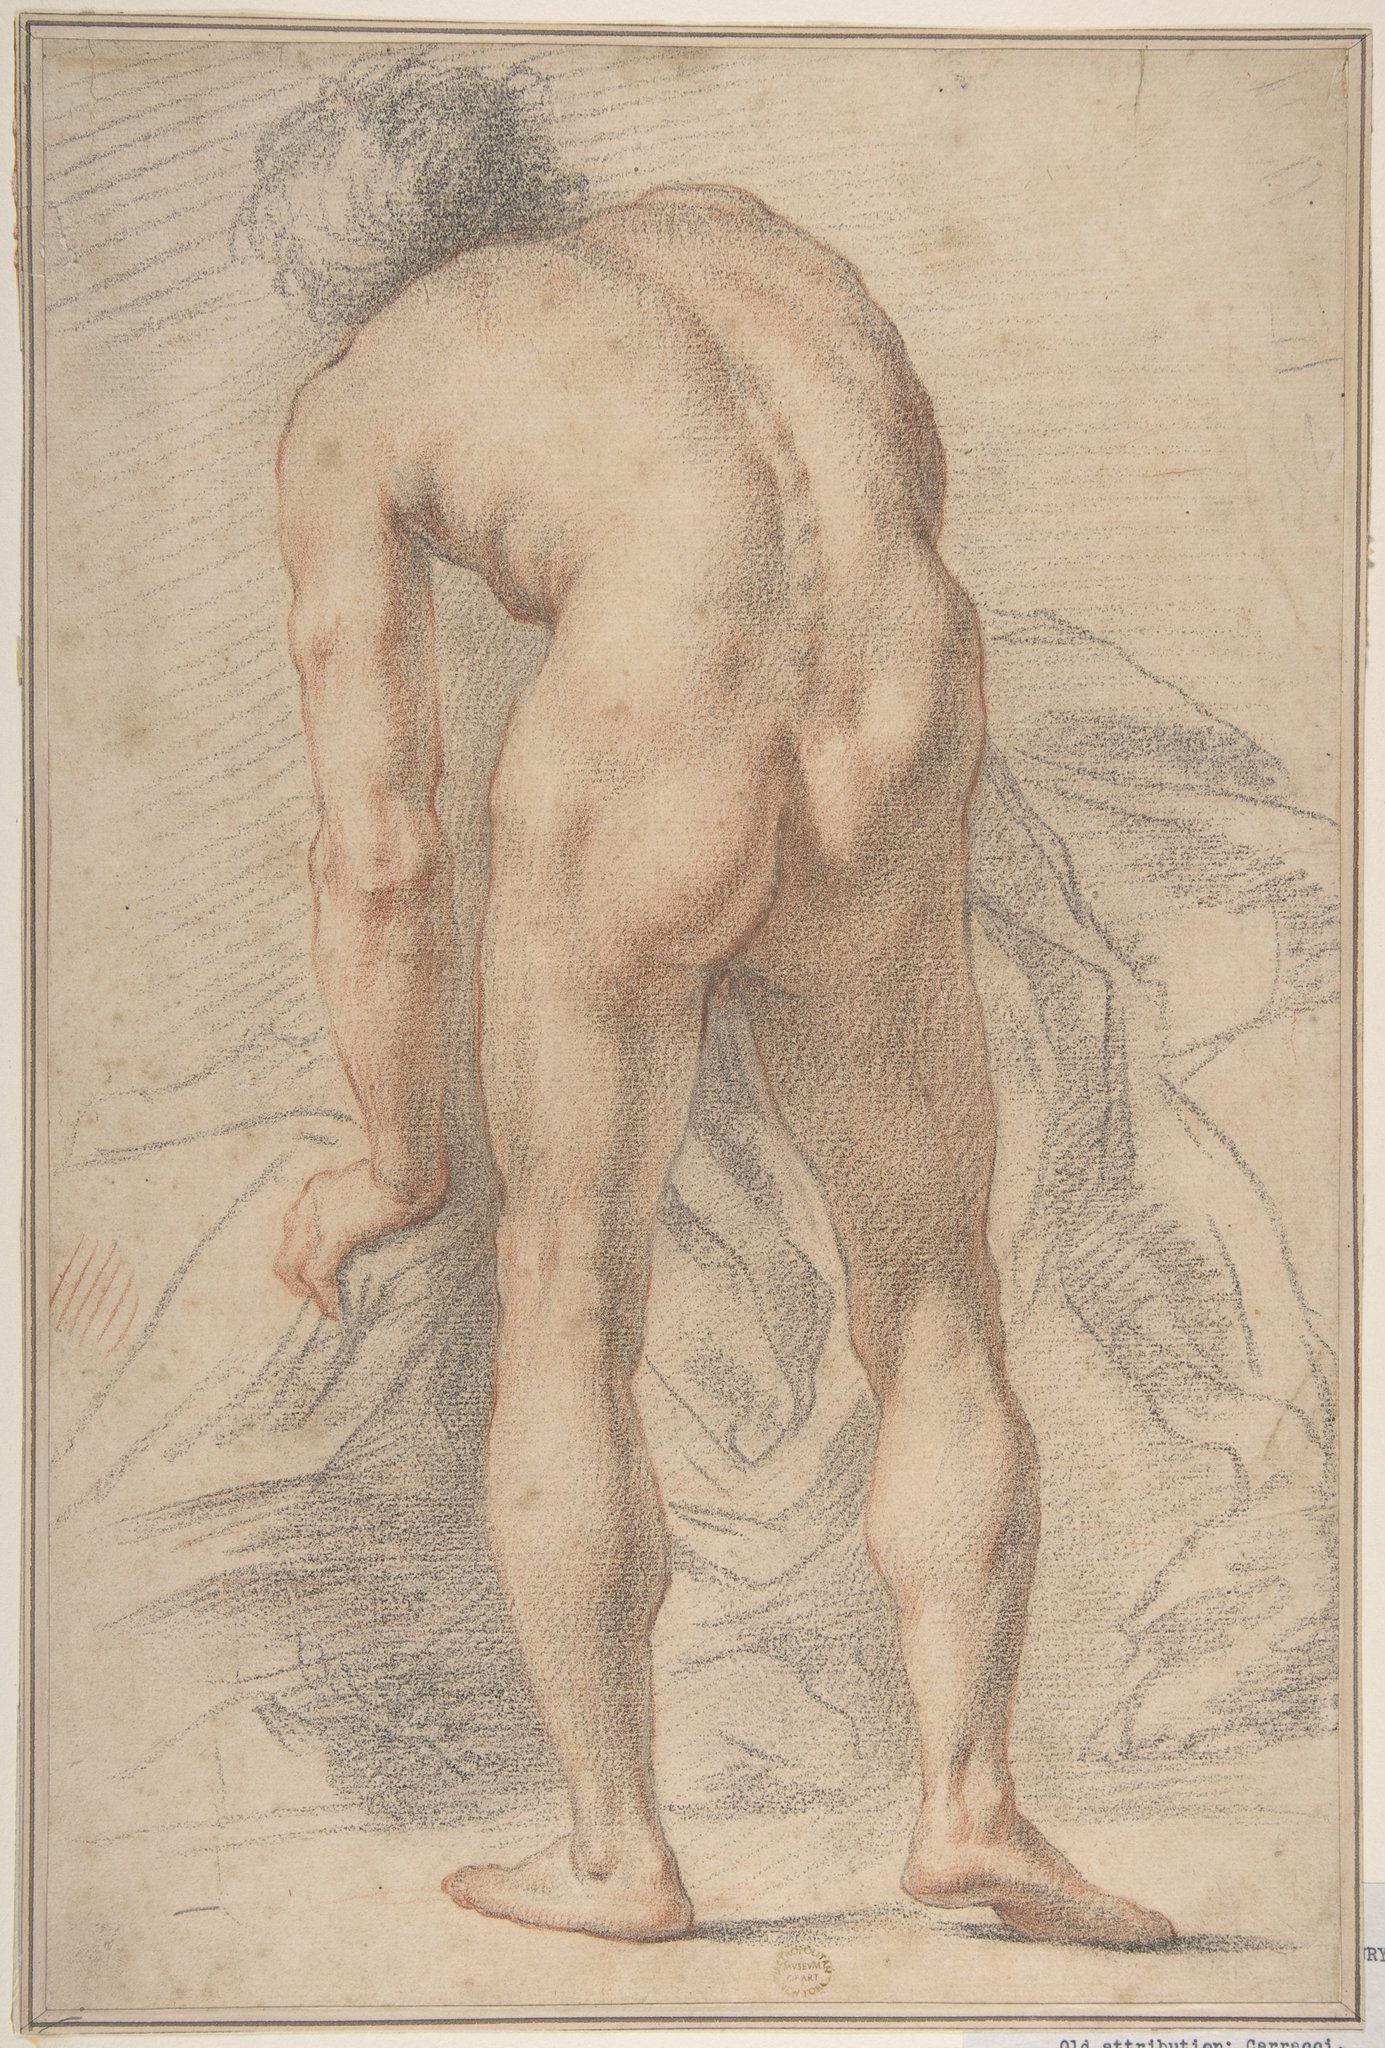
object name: drawing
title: Nude Male Figure, Rear View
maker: giovanni da san giovanni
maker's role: artist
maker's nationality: italian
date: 1701-1800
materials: chalk, paper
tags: male nudes